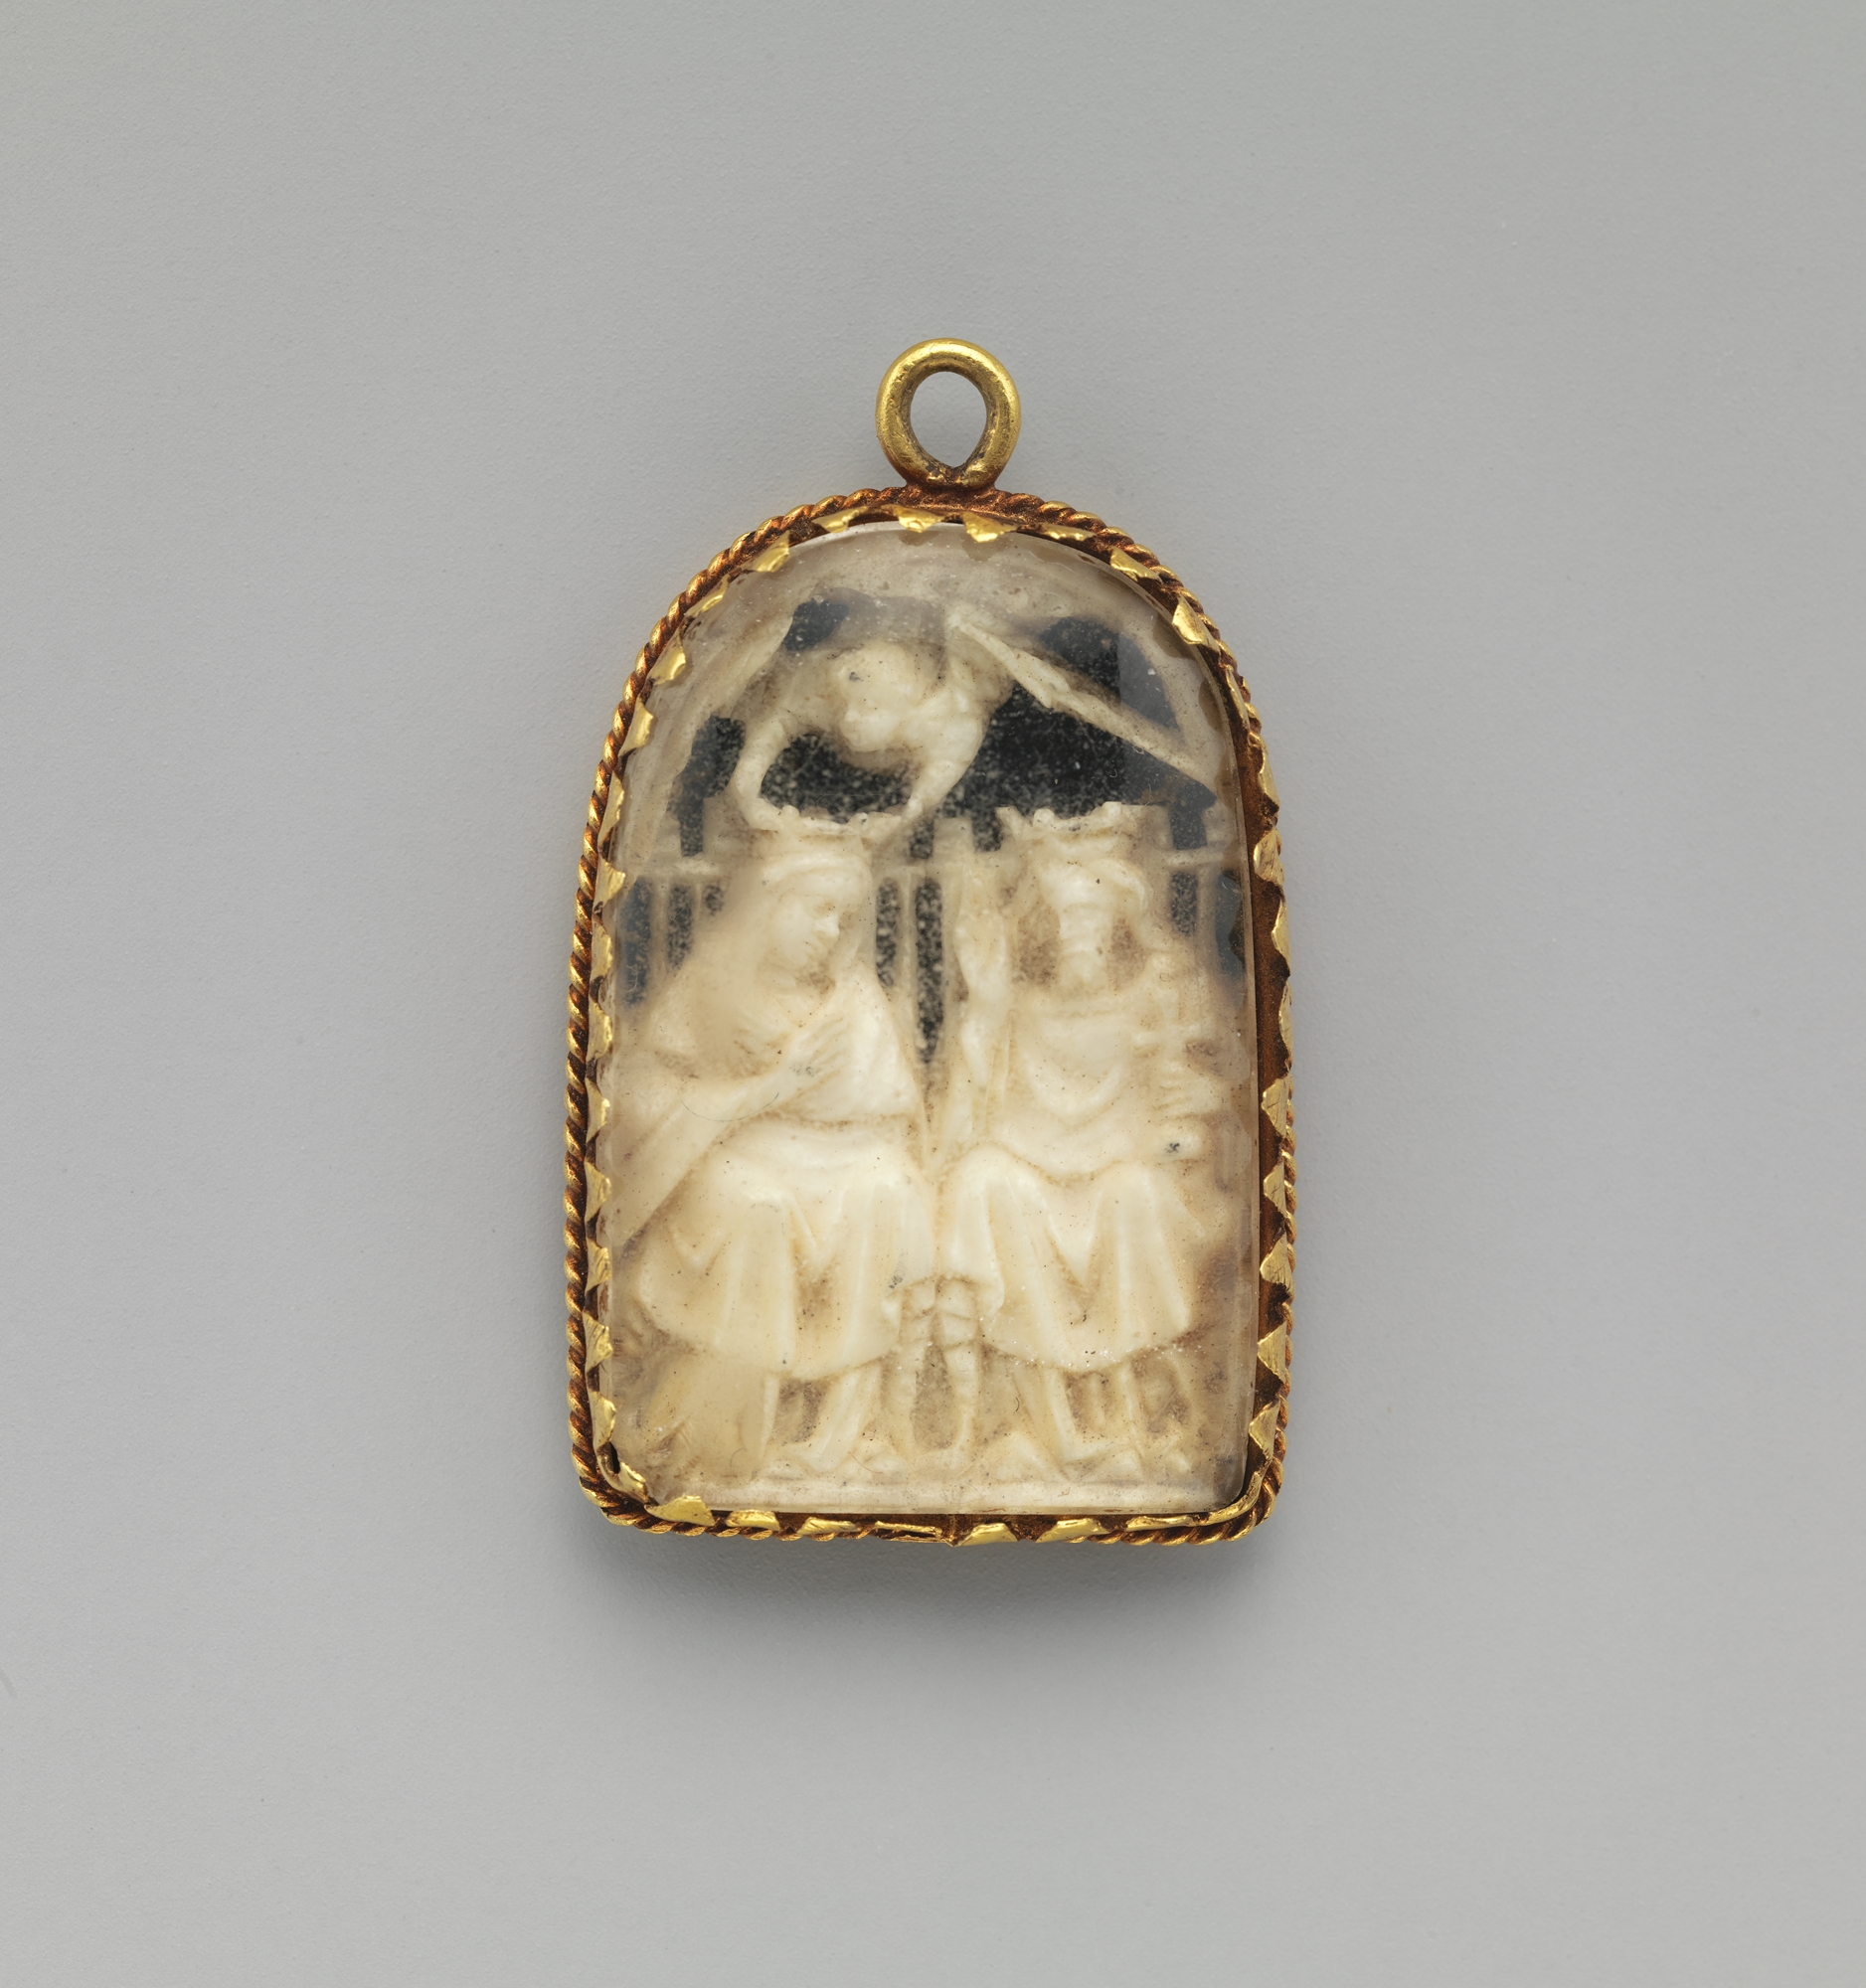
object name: pendant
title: Pendant with the Coronation of the Virgin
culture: french or dutch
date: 1401-1433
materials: gold, ivory, quartz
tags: angels,virgin mary